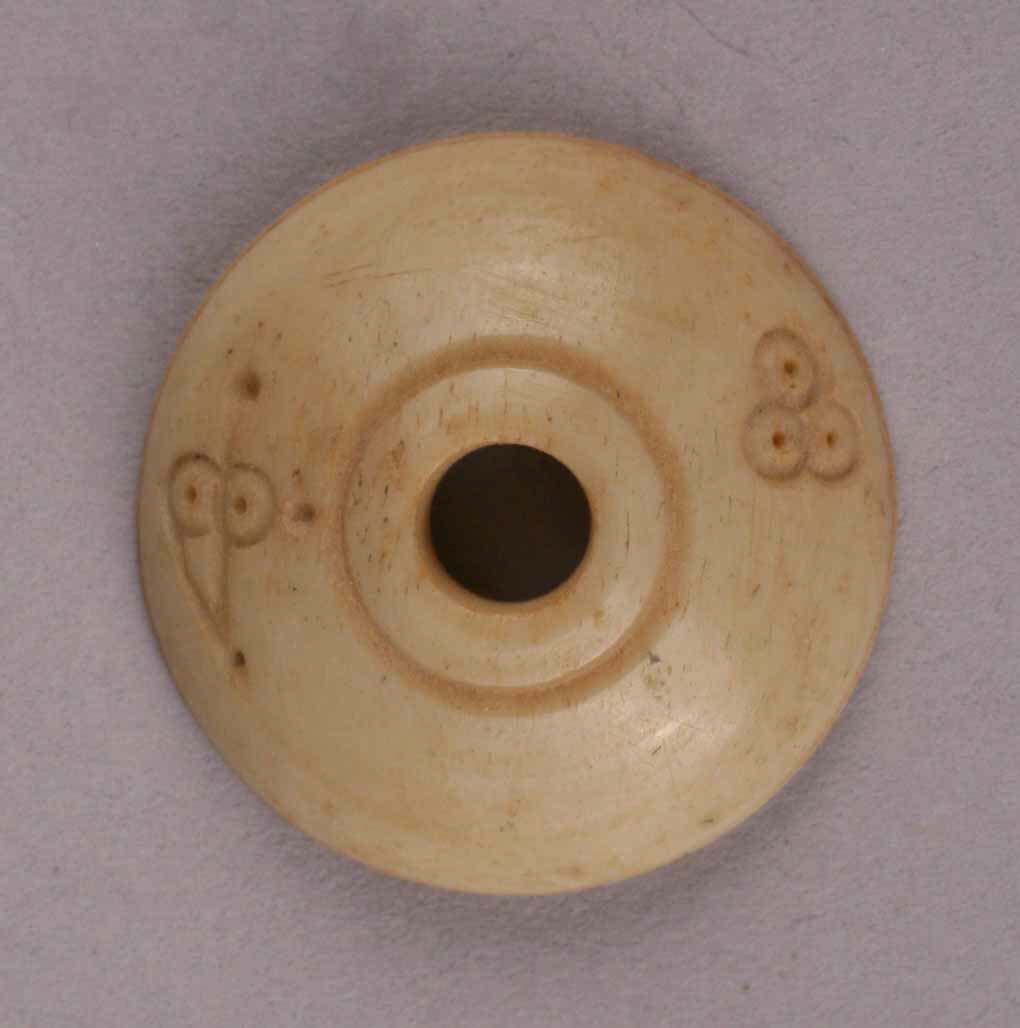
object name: button or bead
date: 801-1000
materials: bone, paint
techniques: incising, inlay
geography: iran